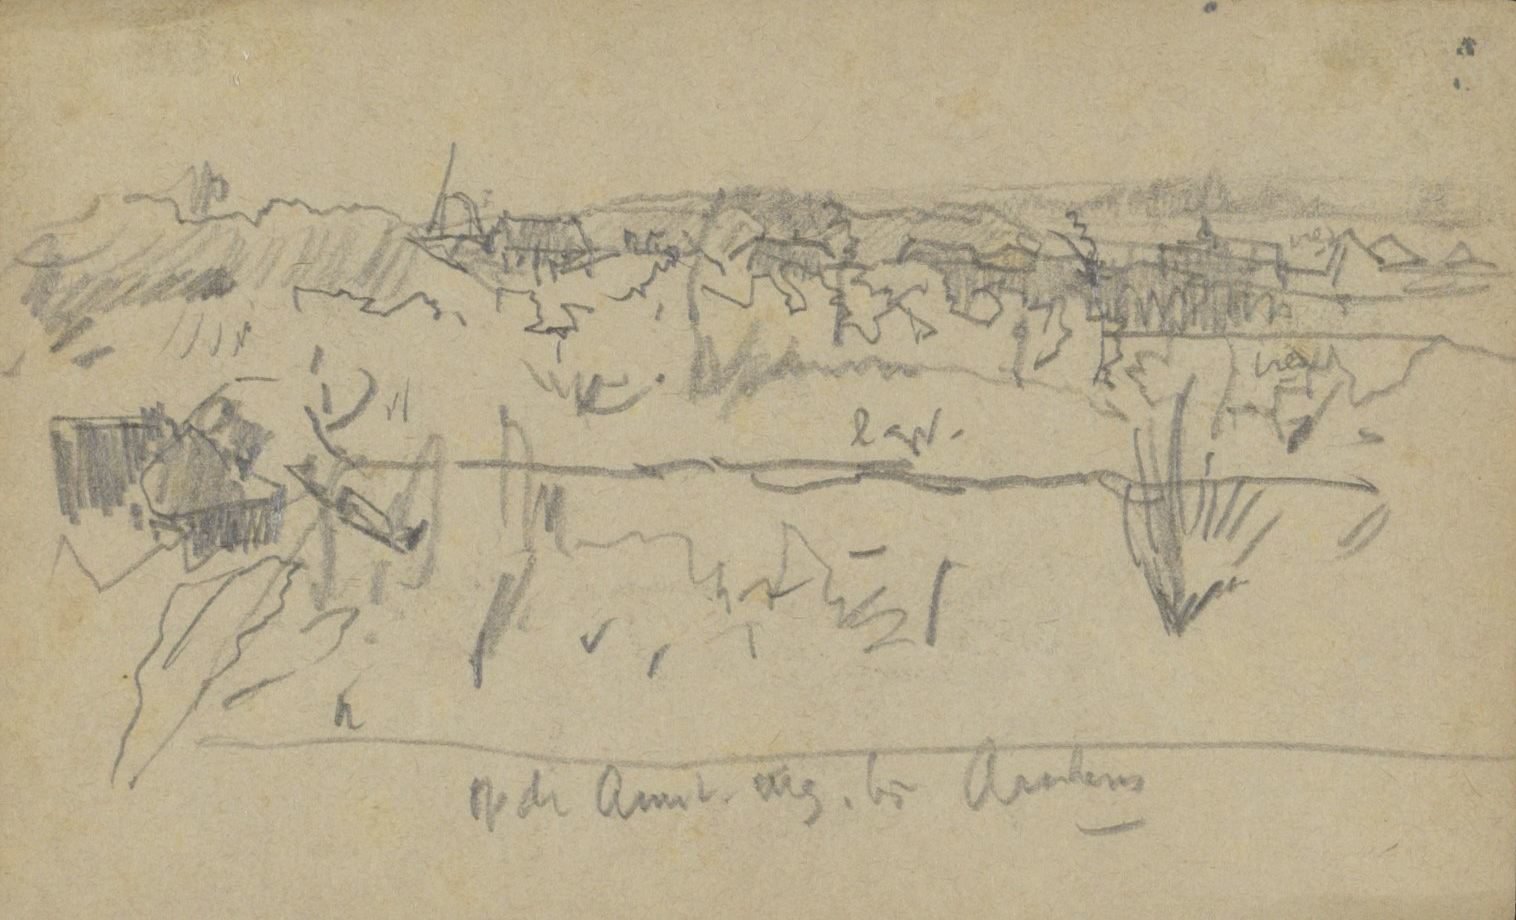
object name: drawing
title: Gezicht op de Amsterdamseweg bij Arnhem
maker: george hendrik breitner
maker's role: draughtsman, painter, print maker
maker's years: 1857-1923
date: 1887-1891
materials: paper, pencil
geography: arnhem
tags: windmill, public road (+ city(-scape) with figures, staffage)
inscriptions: annotation: ‘op de Amst. weg, bij Arnhem’